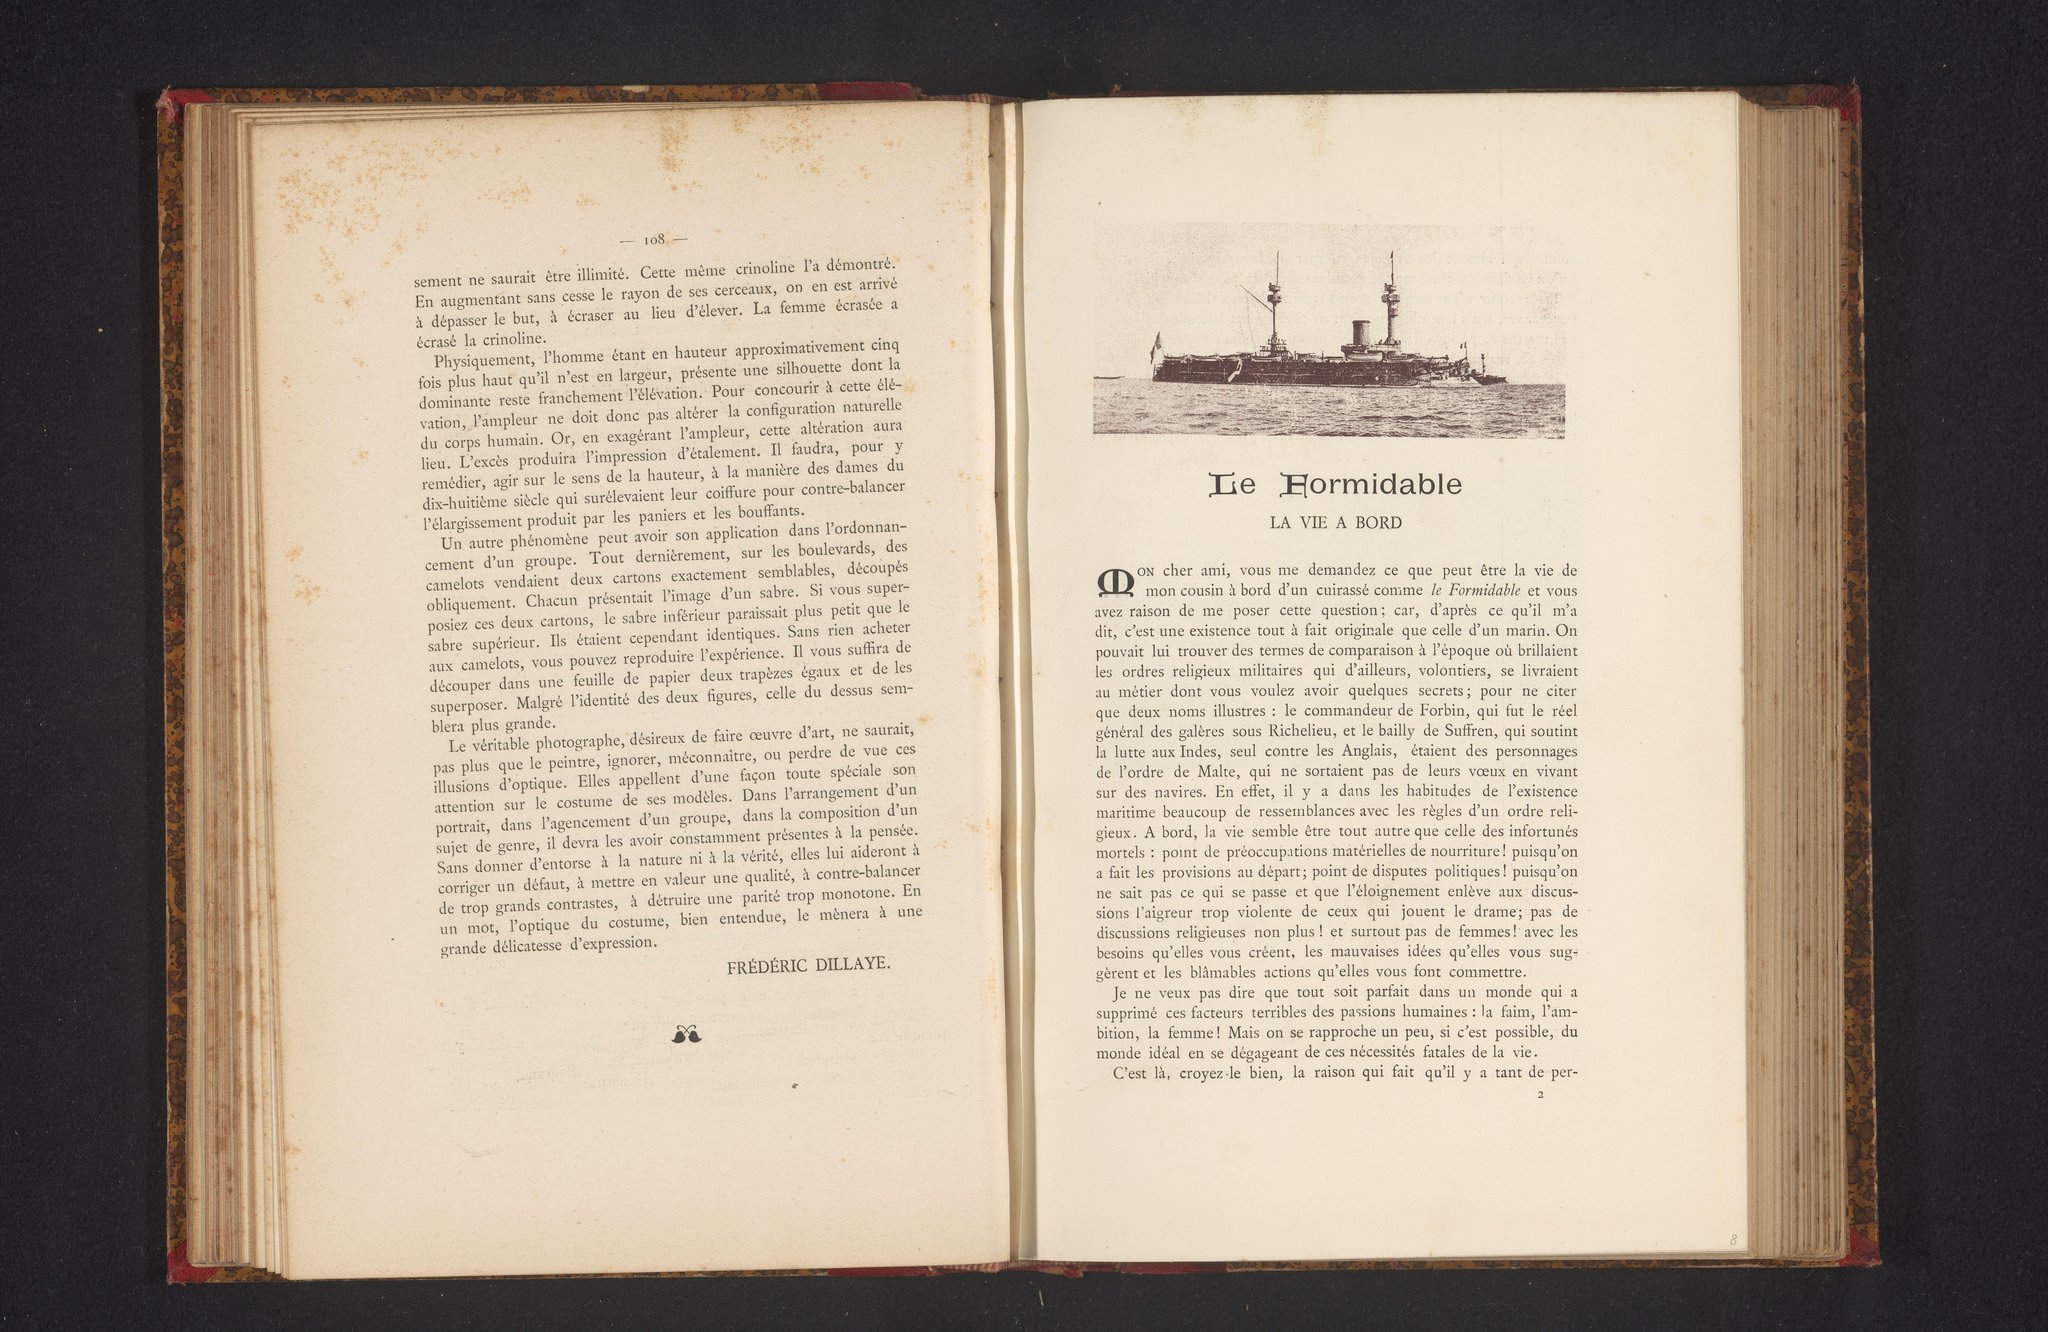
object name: page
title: Gezicht op een oorlogsschip op open water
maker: Anonymous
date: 1888-1893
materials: paper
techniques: photograph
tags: (military) equipment and supply, steamship, motorship